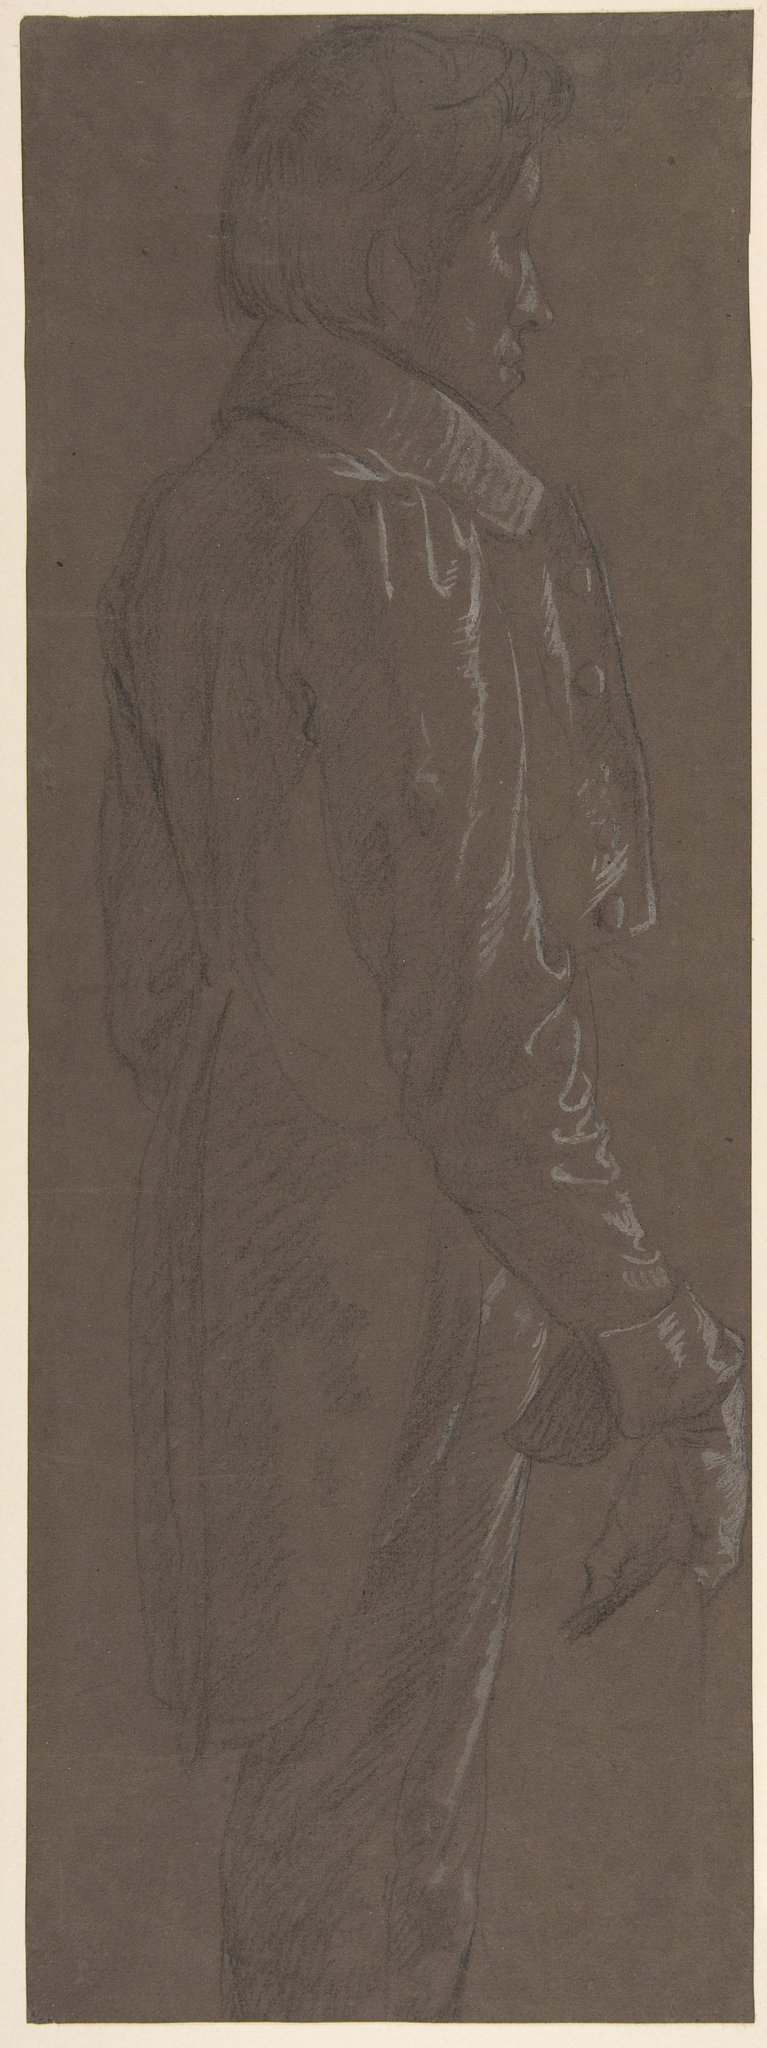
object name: drawing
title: Standing Gentleman, three-quarter length profile facing right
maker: anne louis girodet-trioson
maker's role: artist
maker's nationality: french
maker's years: 1767-1824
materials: chalk, paper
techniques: heightening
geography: france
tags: men,profiles